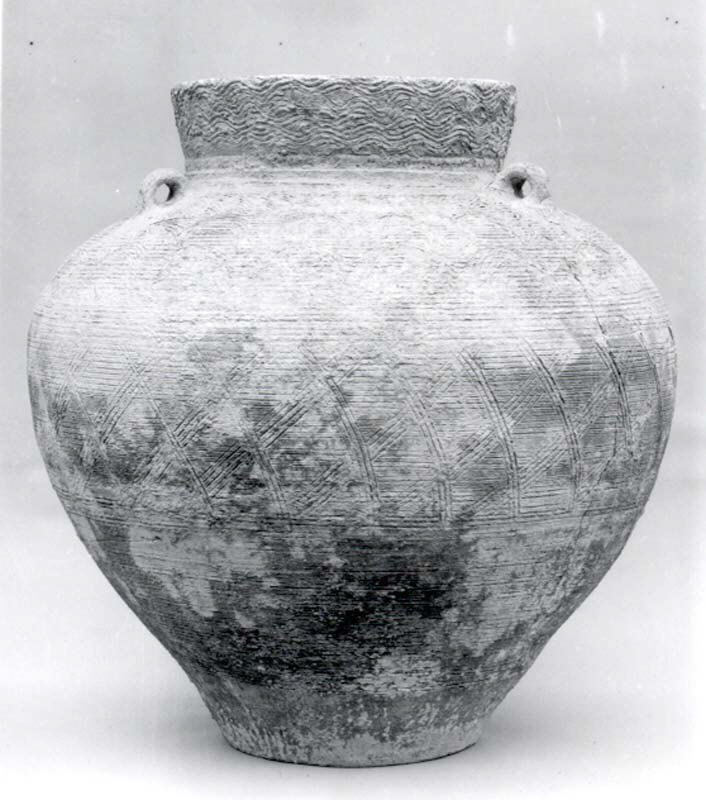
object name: vessel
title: Homreh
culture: sasanian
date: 201-700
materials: ceramic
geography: iran